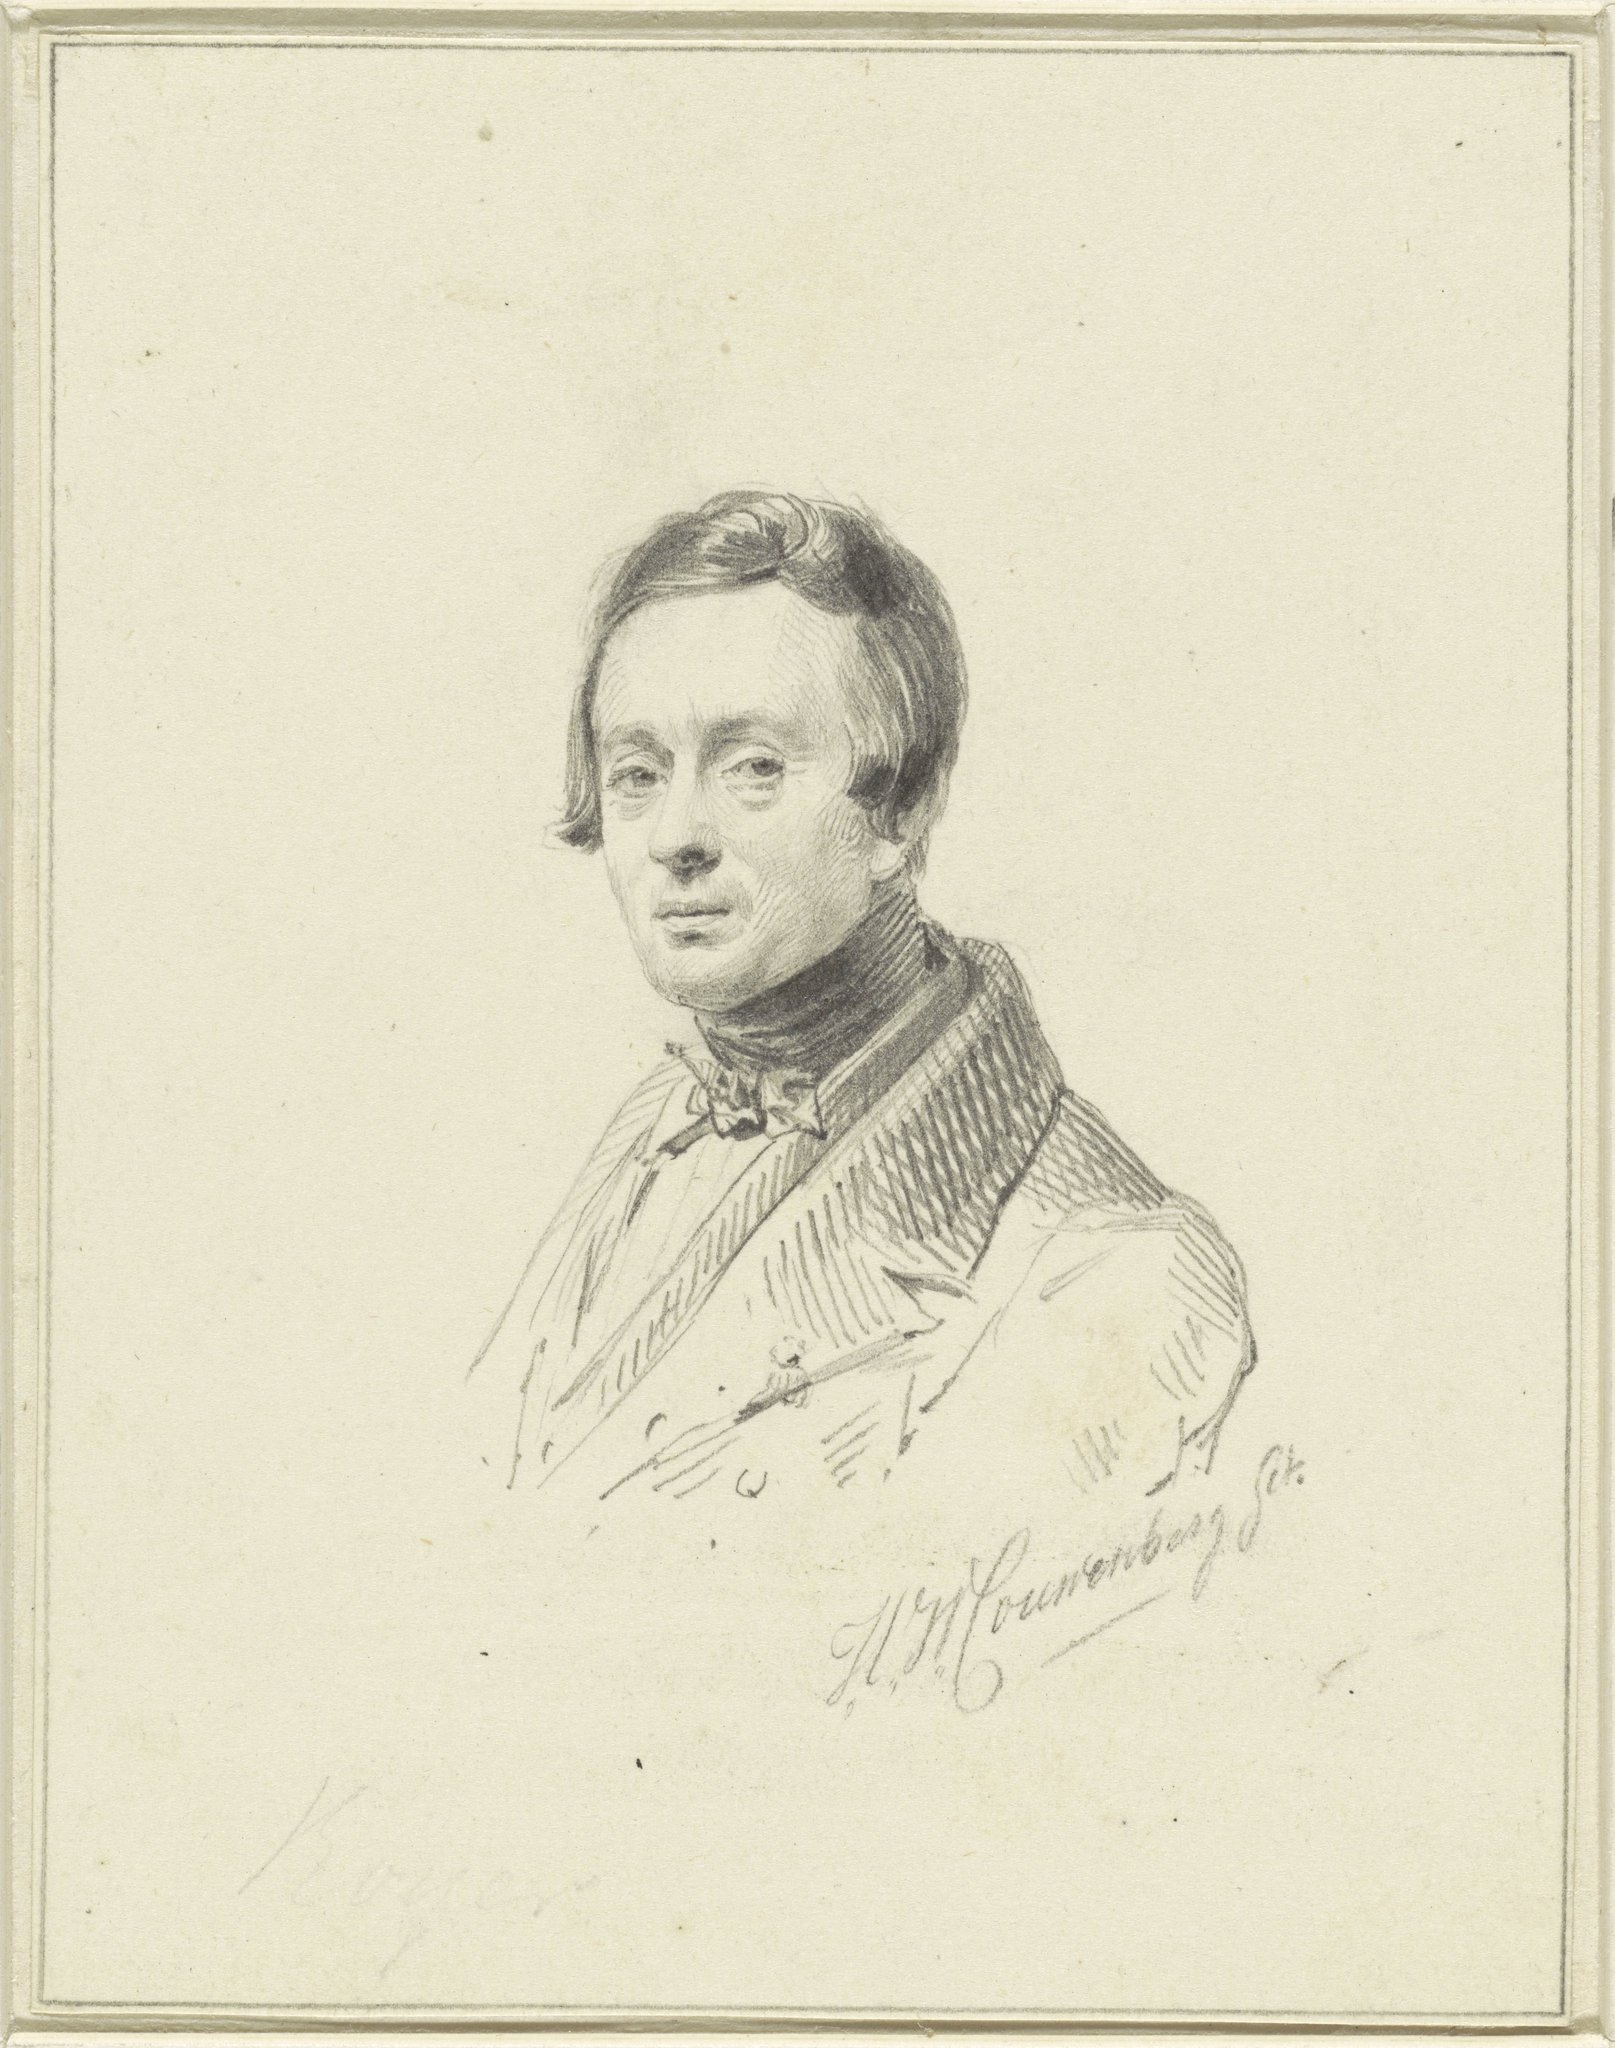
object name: drawing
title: Portret van Louis Royer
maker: henricus wilhelmus couwenberg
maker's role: draughtsman, print maker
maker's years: 1814-1845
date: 1824-1845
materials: paper, pencil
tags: mechelen, sculptor, louis royer, portrait, self-portrait of sculptor, historical persons, portrait, self-portrait of artist